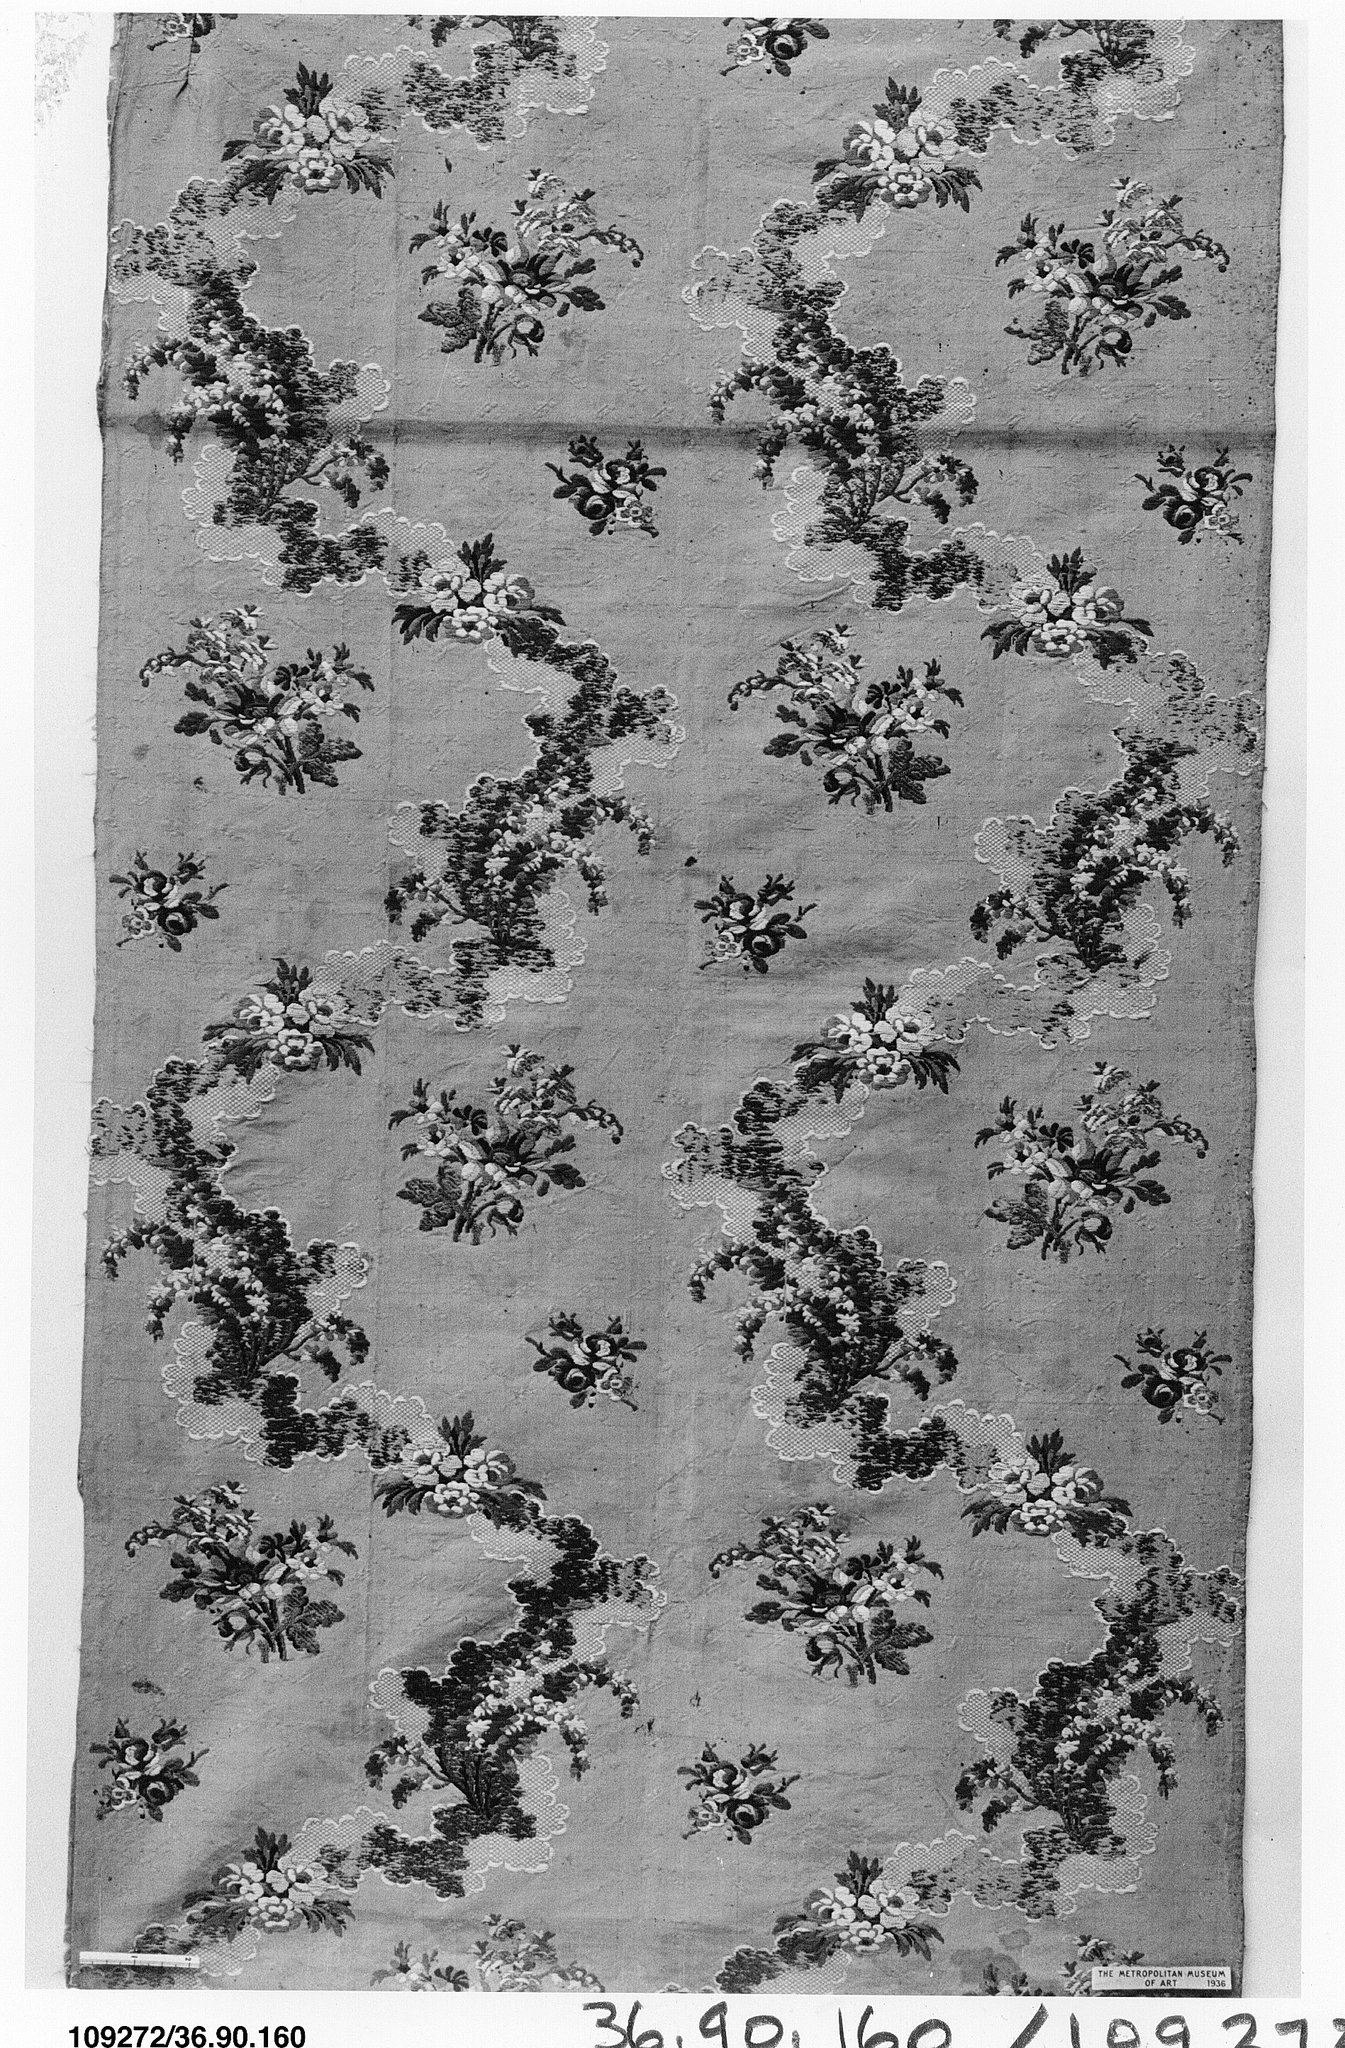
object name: piece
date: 1760-1770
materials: metal thread, silk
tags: flowers